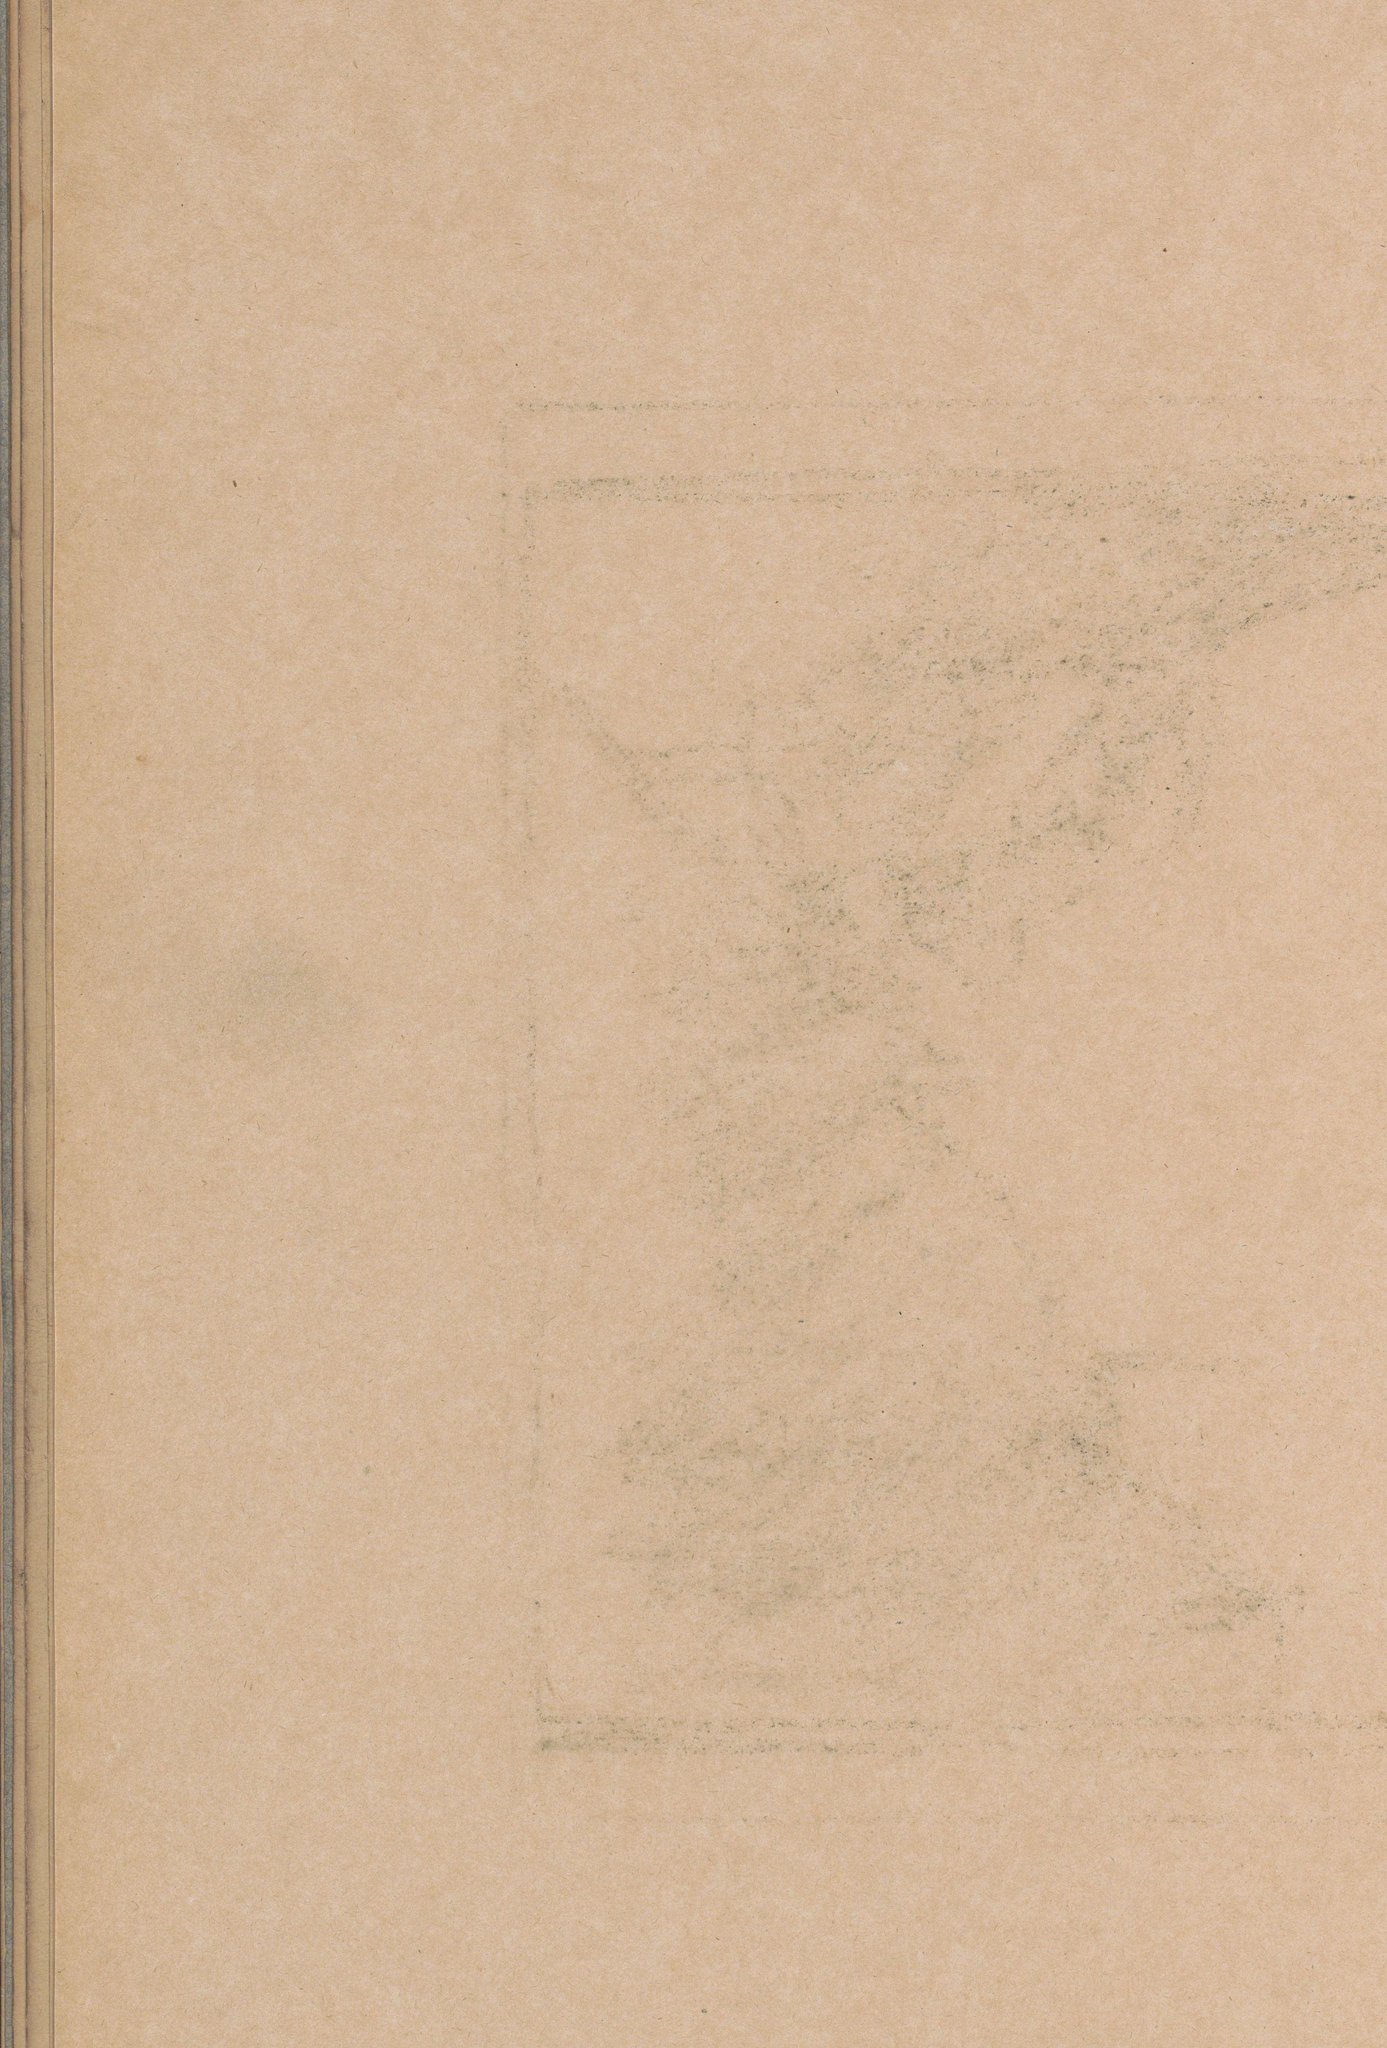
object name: sketchbook leaf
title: Abklatsch van de krijttekening op pagina 61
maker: willem witsen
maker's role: draughtsman, painter, print maker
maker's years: 1860-1923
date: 1884-1887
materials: paper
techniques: printmaking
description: Pagina 60 uit een schetsboek met 38 bladen.